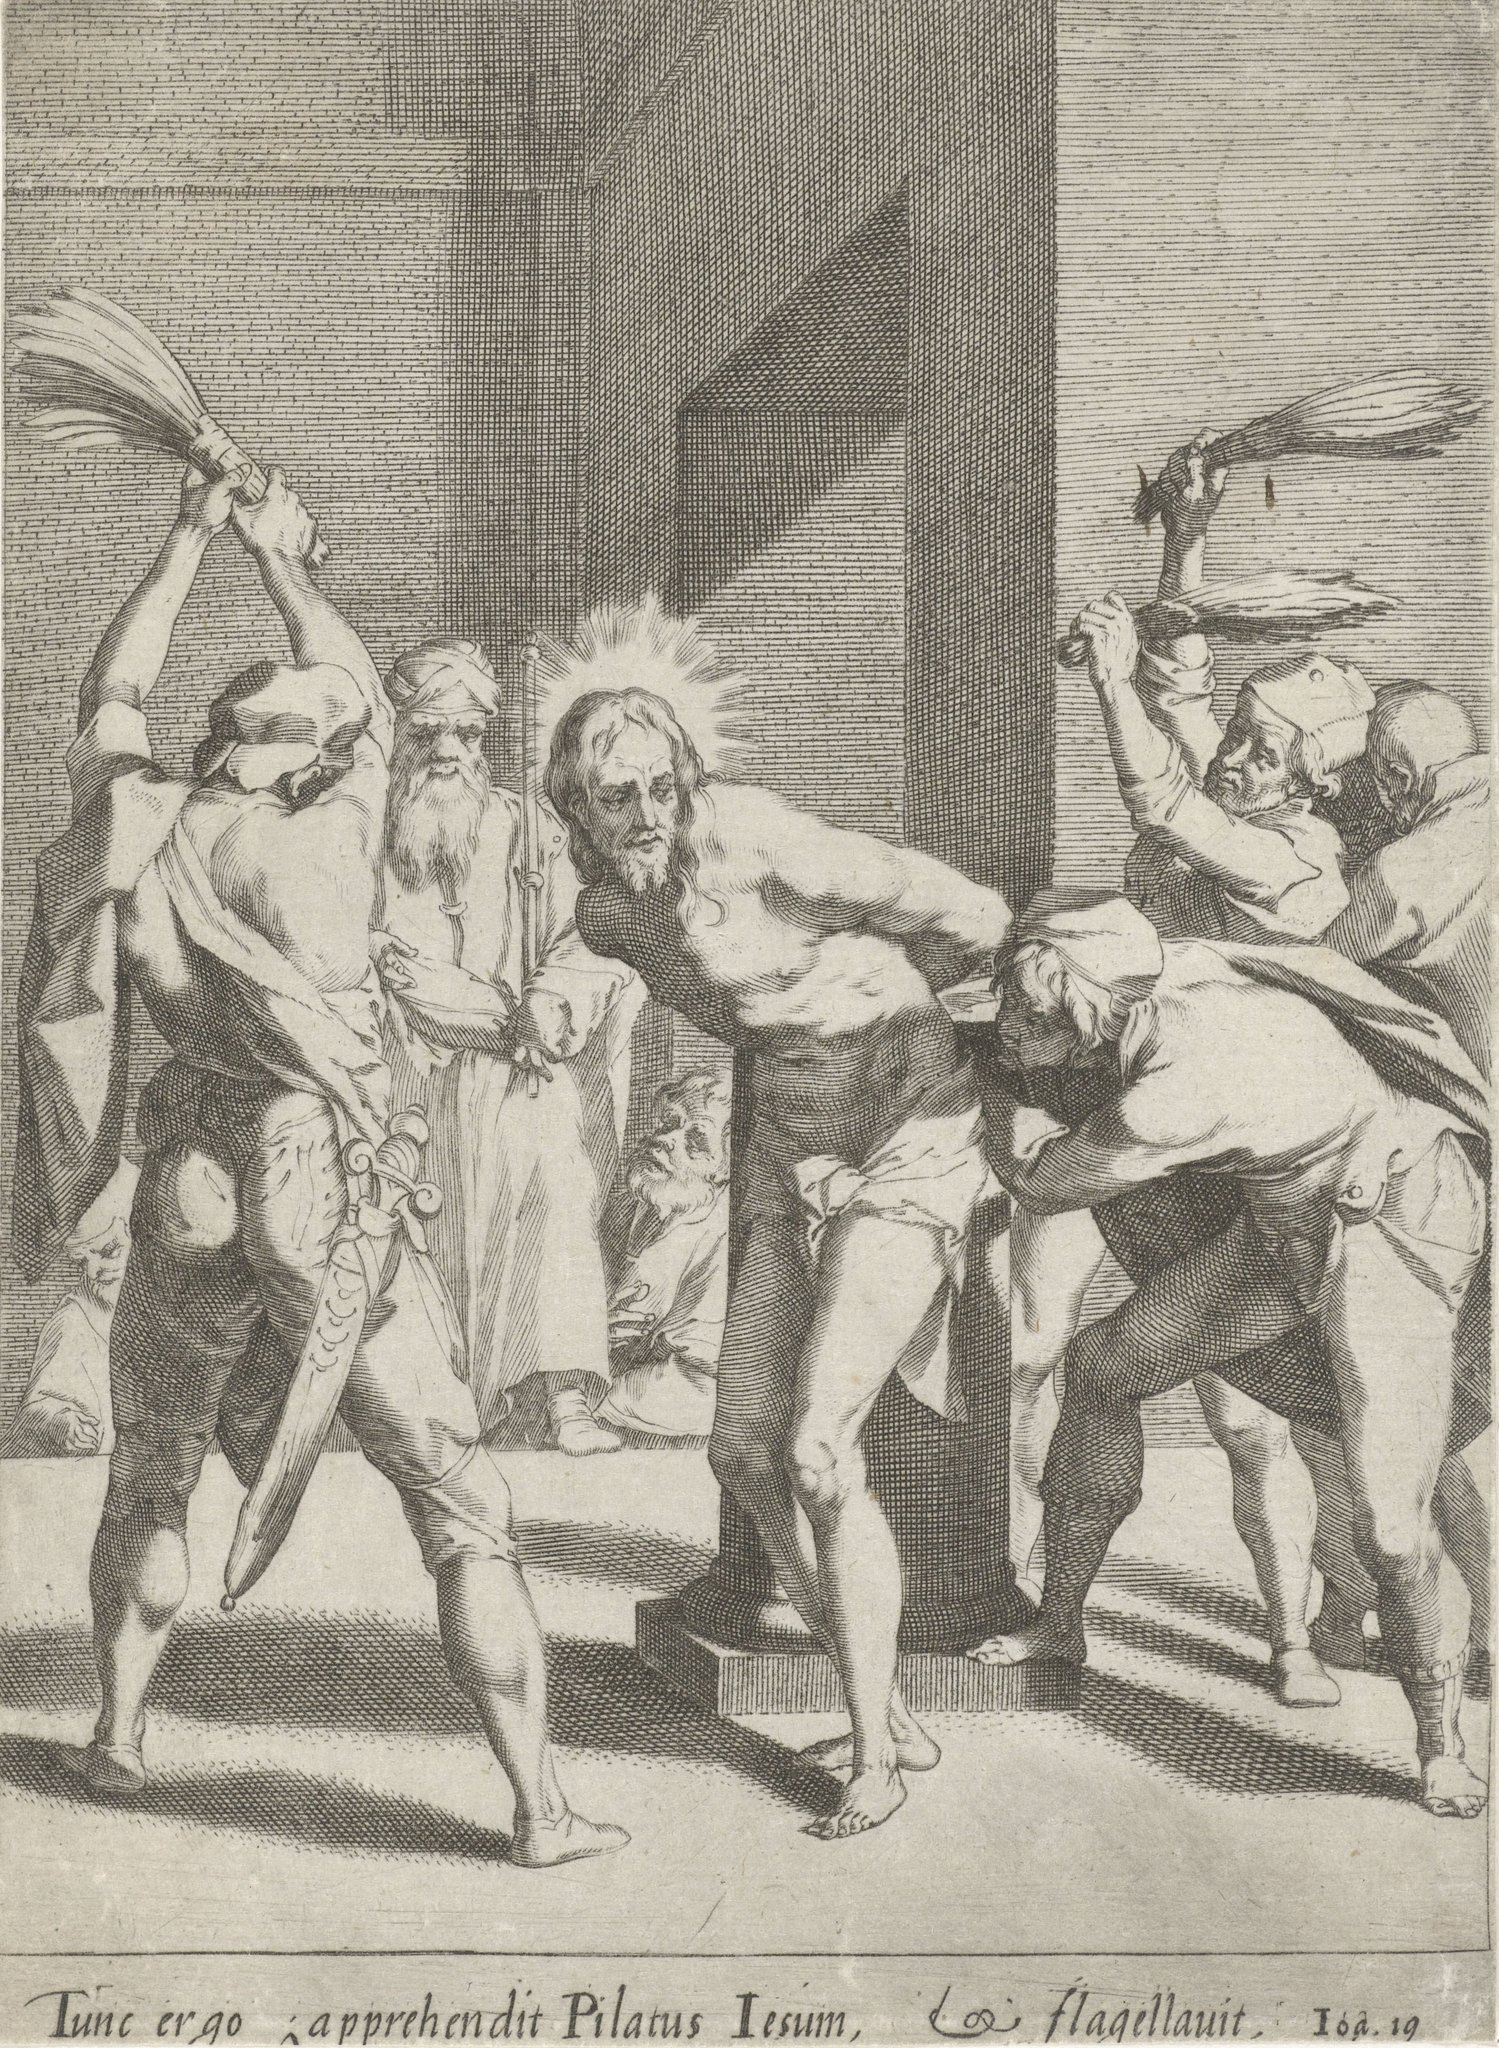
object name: print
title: Passionis et resurrectionis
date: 1590-1632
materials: paper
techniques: engraving, etching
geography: italy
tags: flagellation by soldiers, christ usually tied to a column (matthew 27:26; mark 15:15; john 19:1)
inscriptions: collector's mark: Lugt 2228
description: Christus, op lendendoek na naakt en vastgebonden aan een pilaar, wordt door soldaten gegeseld. Op de achtergrond Pilatus. In de marge een onderschrift in het Latijn. Prent uit een serie van vijftien met de passie van Christus.